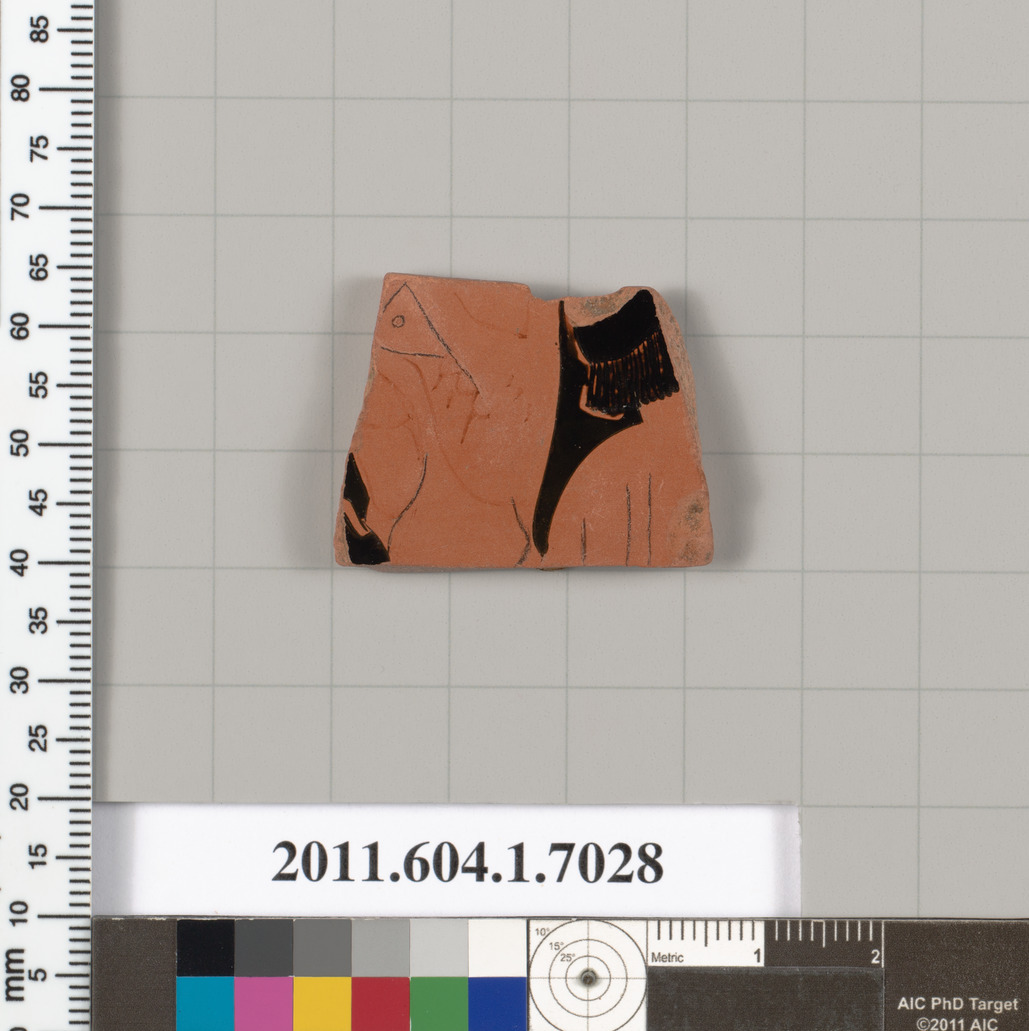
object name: kylix fragment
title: Terracotta fragment of a kylix (drinking cup)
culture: greek, attic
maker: douris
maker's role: artist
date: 500-480 BCE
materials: terracotta